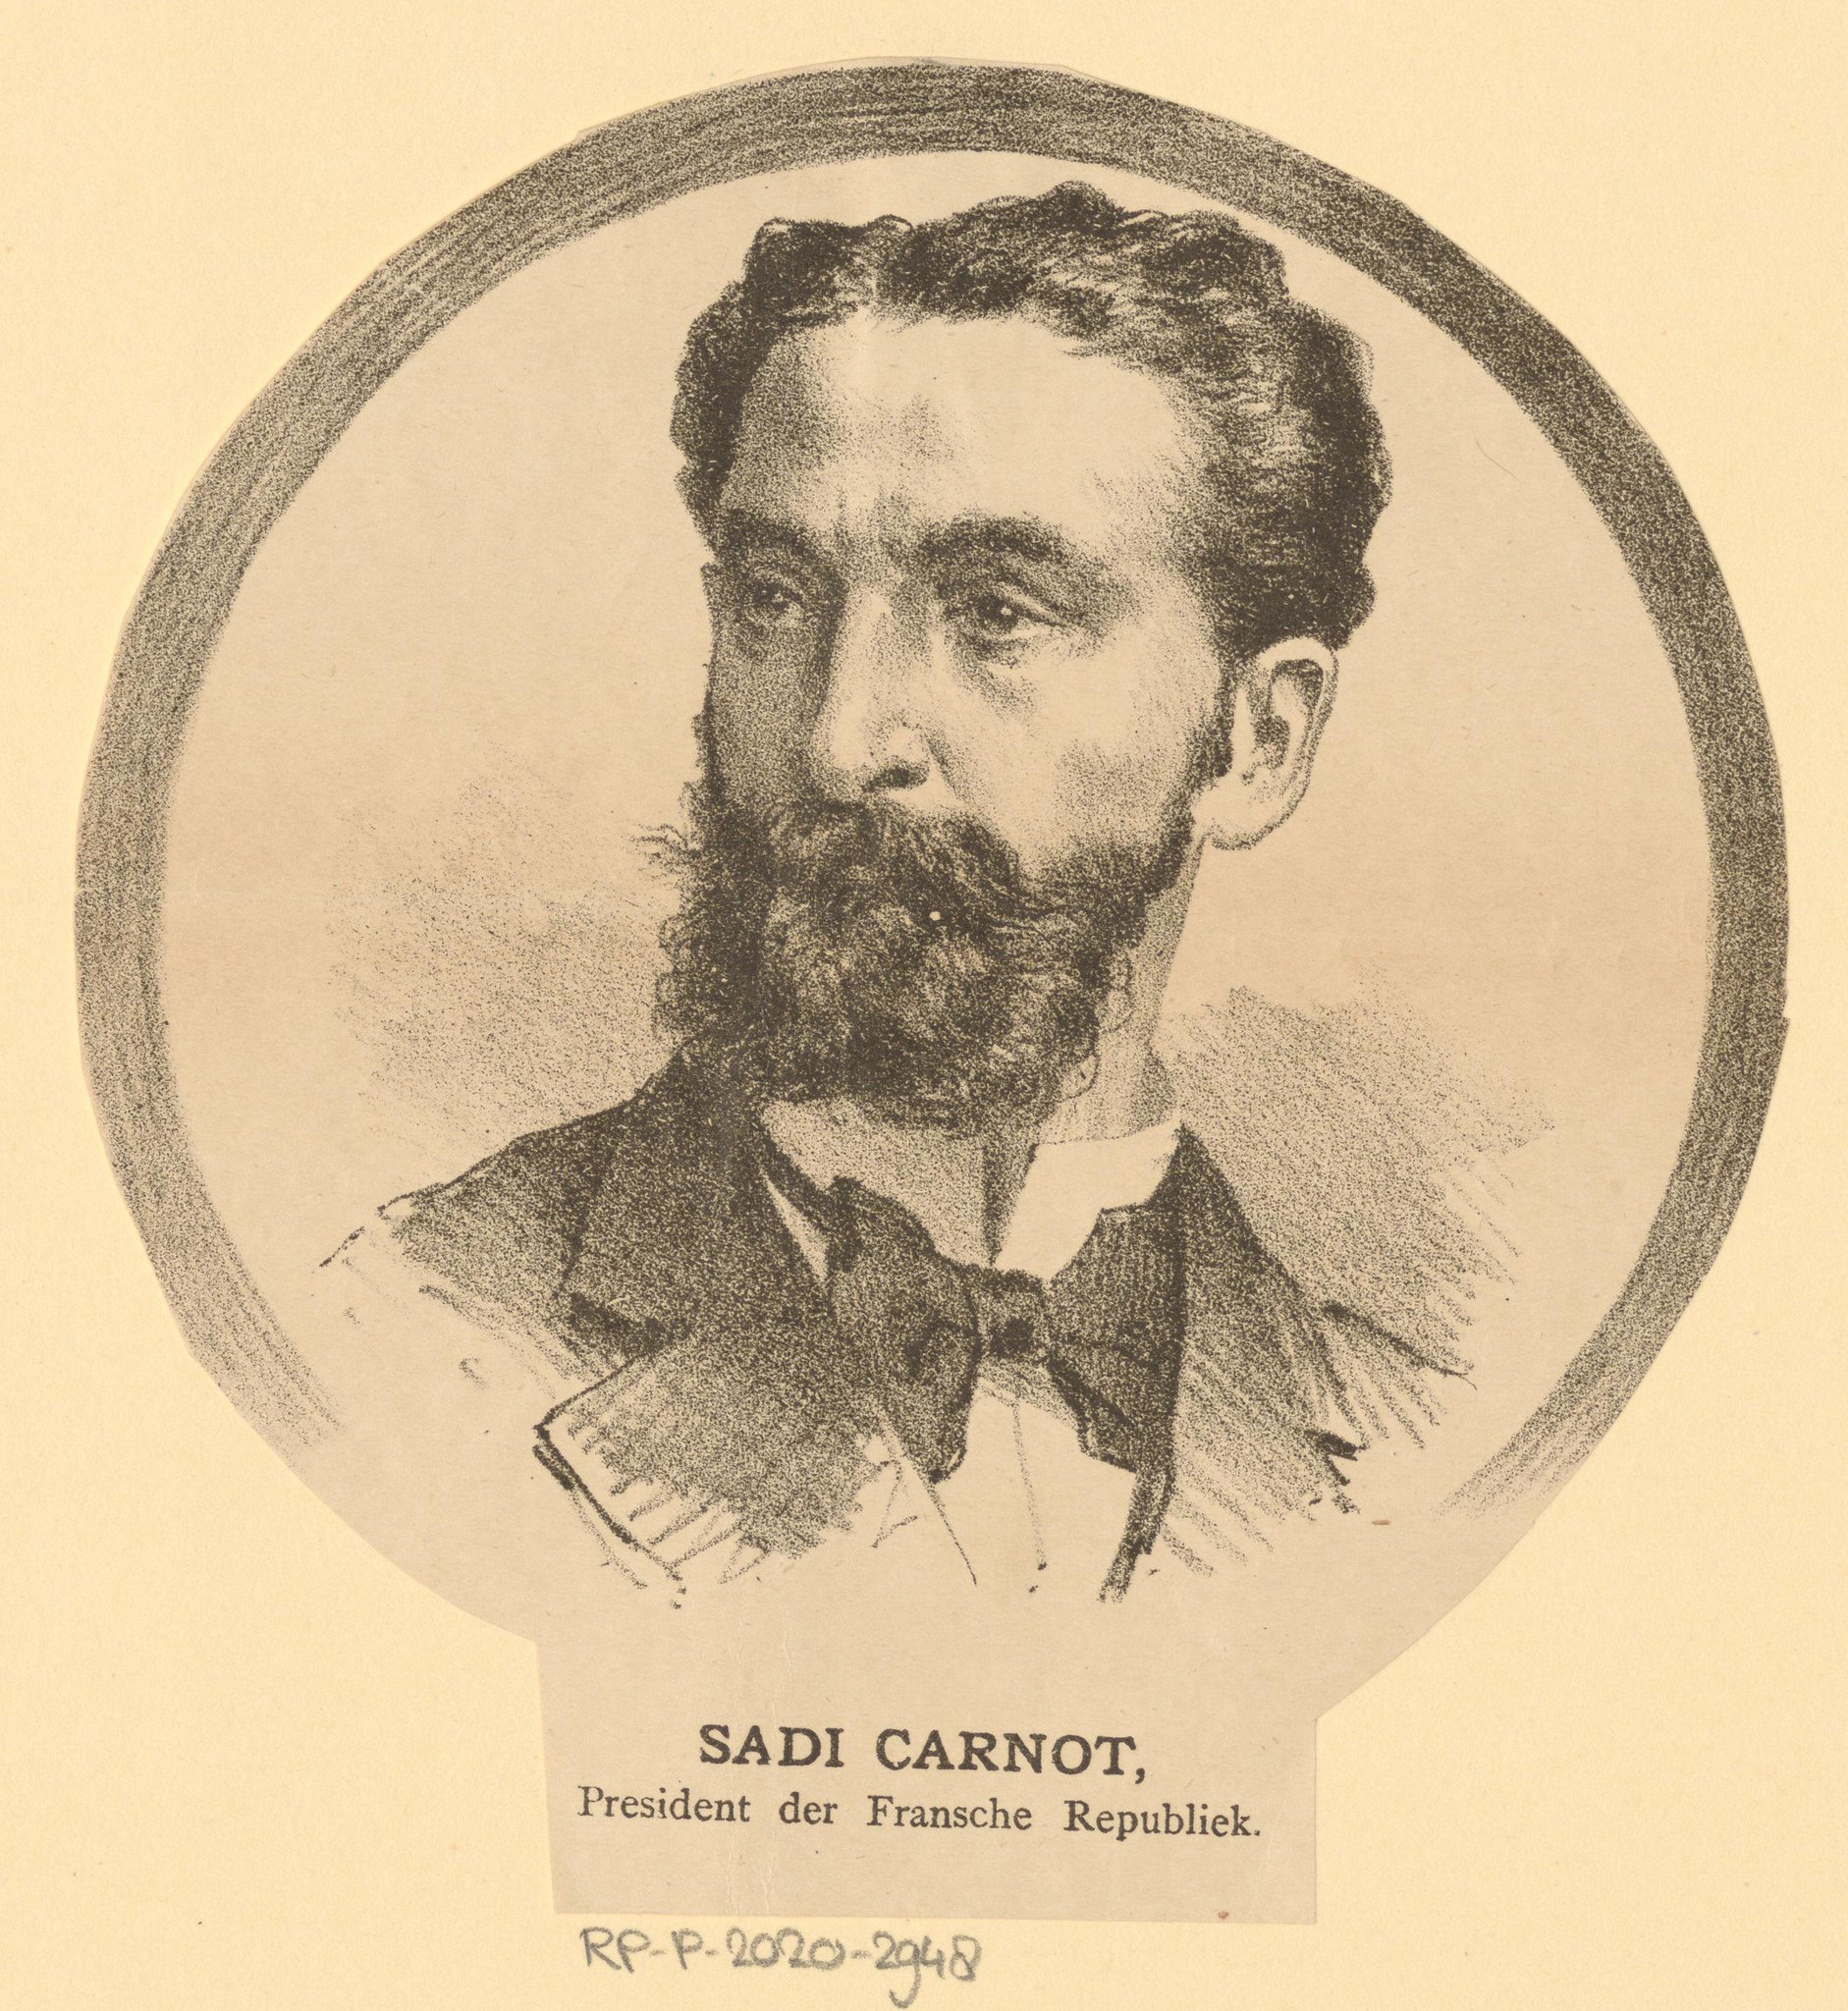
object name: print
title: Portret van Marie François Sadi Carnot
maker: Anonymous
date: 1887-1894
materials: paper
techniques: letterpress printing, lithograph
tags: historical persons